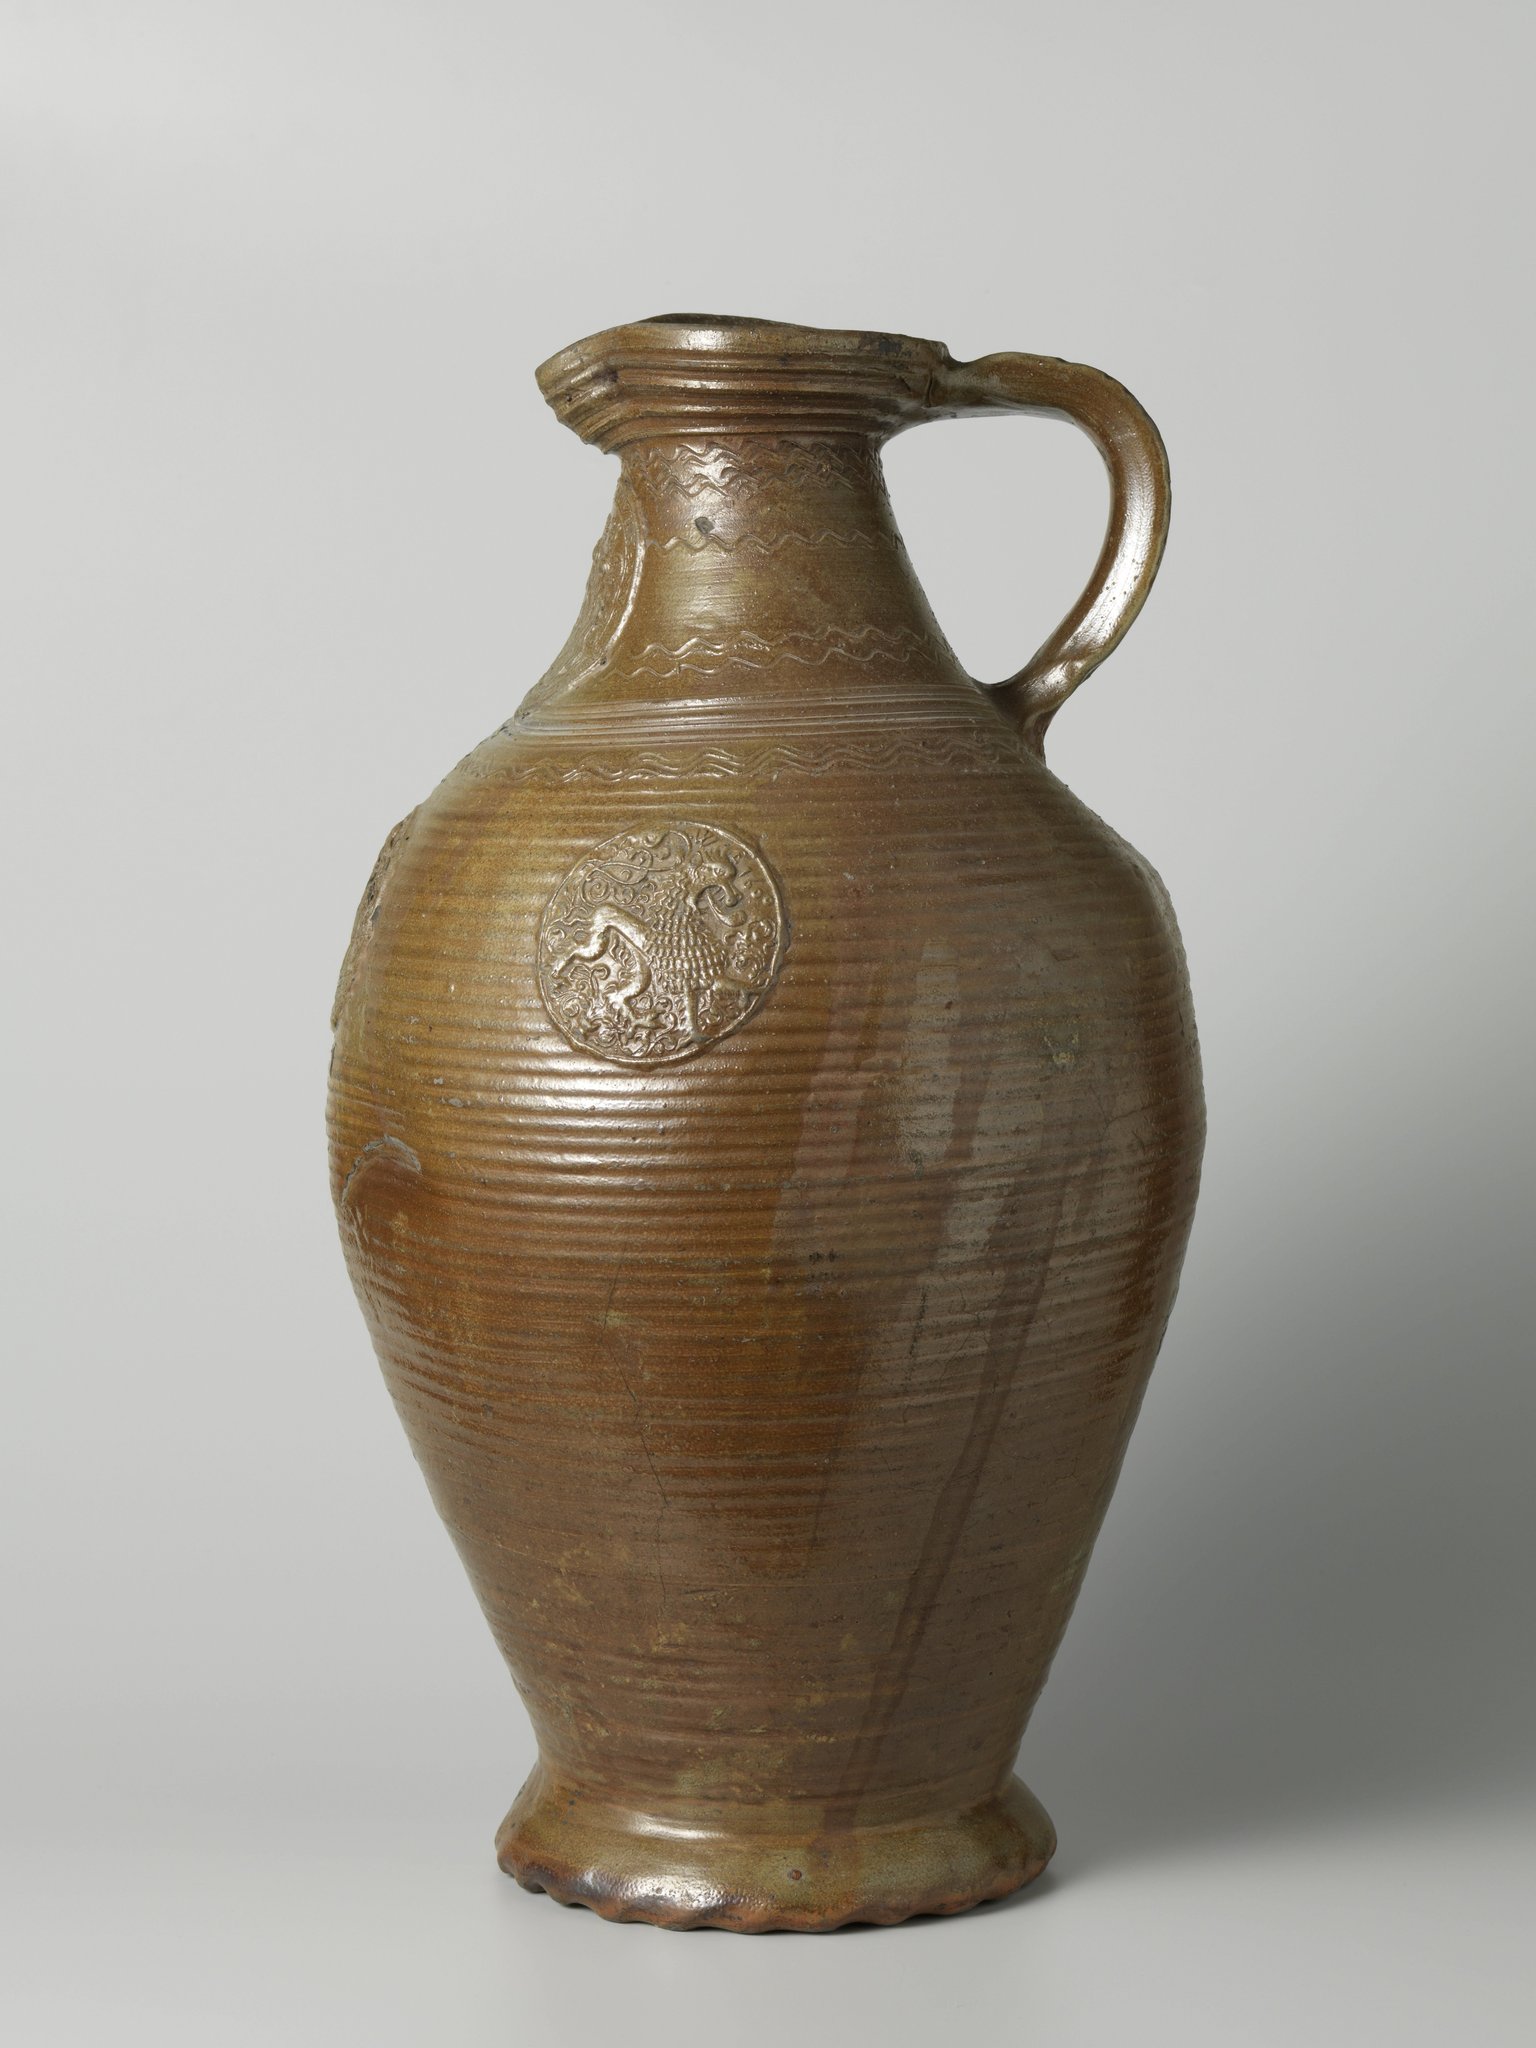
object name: voorraadkan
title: Storrage vessel with a coat of arms and lions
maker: Anonymous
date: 1604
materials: engobe, glaze, stoneware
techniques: firing, forming, relief, turning, vitrification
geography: langerwehe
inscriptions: date: ‘1600/ 1604’, inscription: ‘I.WILHELMVS.VO.REIFENBERG M.I.ANNA VOM BATEMBORG.1604’, mark: ‘W.E.’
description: Voorraadkan van steengoed op golvende voet met een eivormig lichaam en wijde nek met een geknepen tuit. Het C-vormige oor is bevestigd aan de nek en de schouder. Profielen op de nek en schouder. Bedekt met een bruine engobe. De kan is versierd met draairingen. Op de nek in reliëf een gedrukt en opgelegd medaillon met een wapen en het randschrift 'I.WILHELMVS.VO.REIFENBERG M.I.ANNA VOM BATEMBORG.1604'. De buik met drie kleinere medaillons met een leeuw, het merk 'W.E.' en de datum '1600'. Op de nek en de schouder banden met ingegrifte, golvende lijnen. Langerwehe.